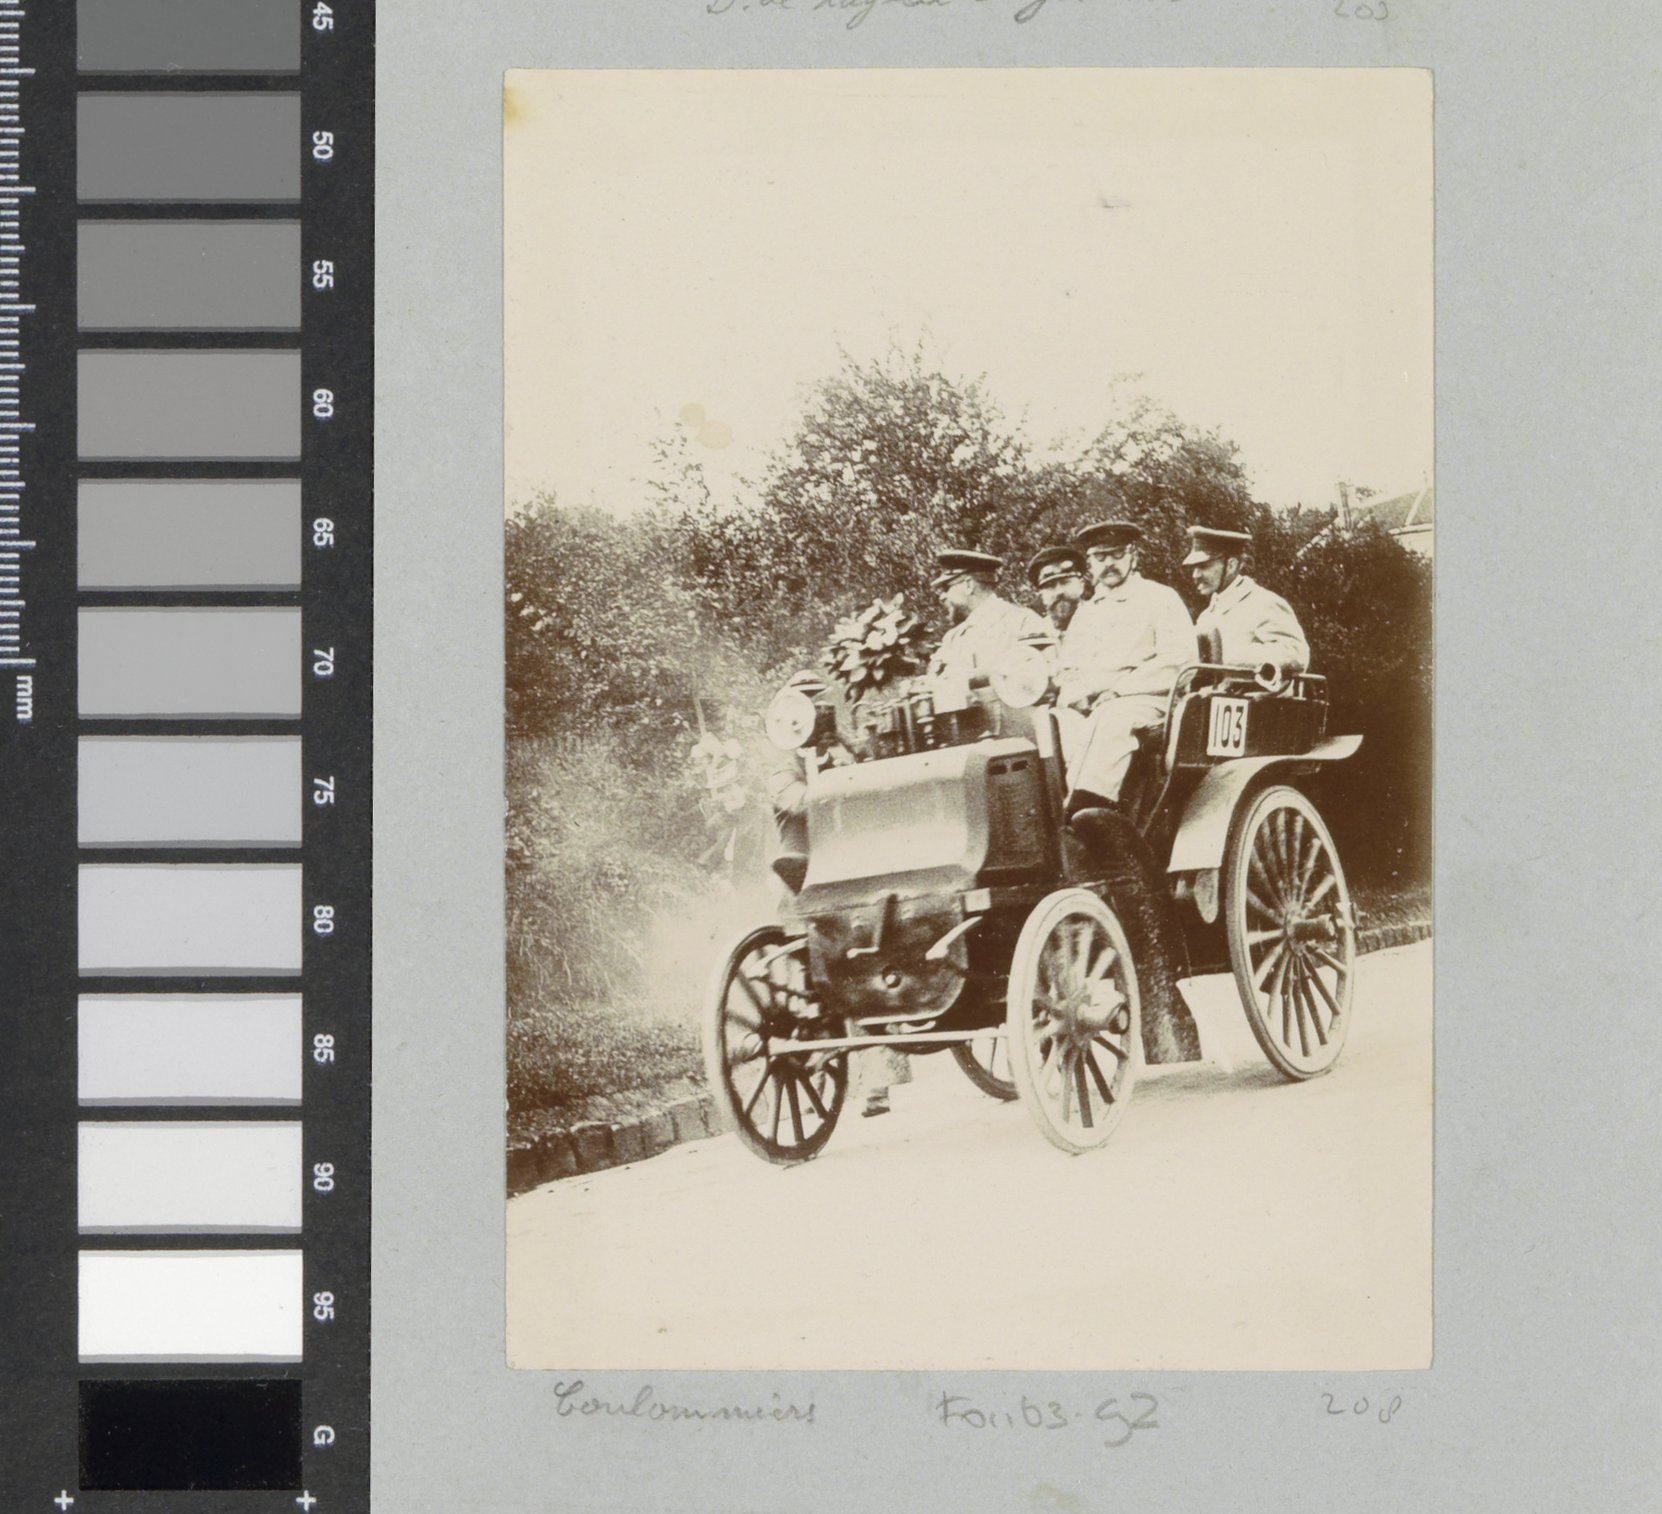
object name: photograph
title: Deelnemers aan de race Parijs-Amsterdam voor automobielen onderweg te Coulommiers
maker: delizy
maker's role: manufacturer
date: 1898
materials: paper, photographic support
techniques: gelatin silver print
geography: coulommiers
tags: motorcar racing, automobile, street (+ city(-scape) with figures, staffage)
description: Onderdeel van Fotoalbum van een Franse amateurfotograaf met opnames van uitstapjes in Frankrijk, Spanje, België, Luxemburg en Nederland, de eerste automobielen en autoraces.